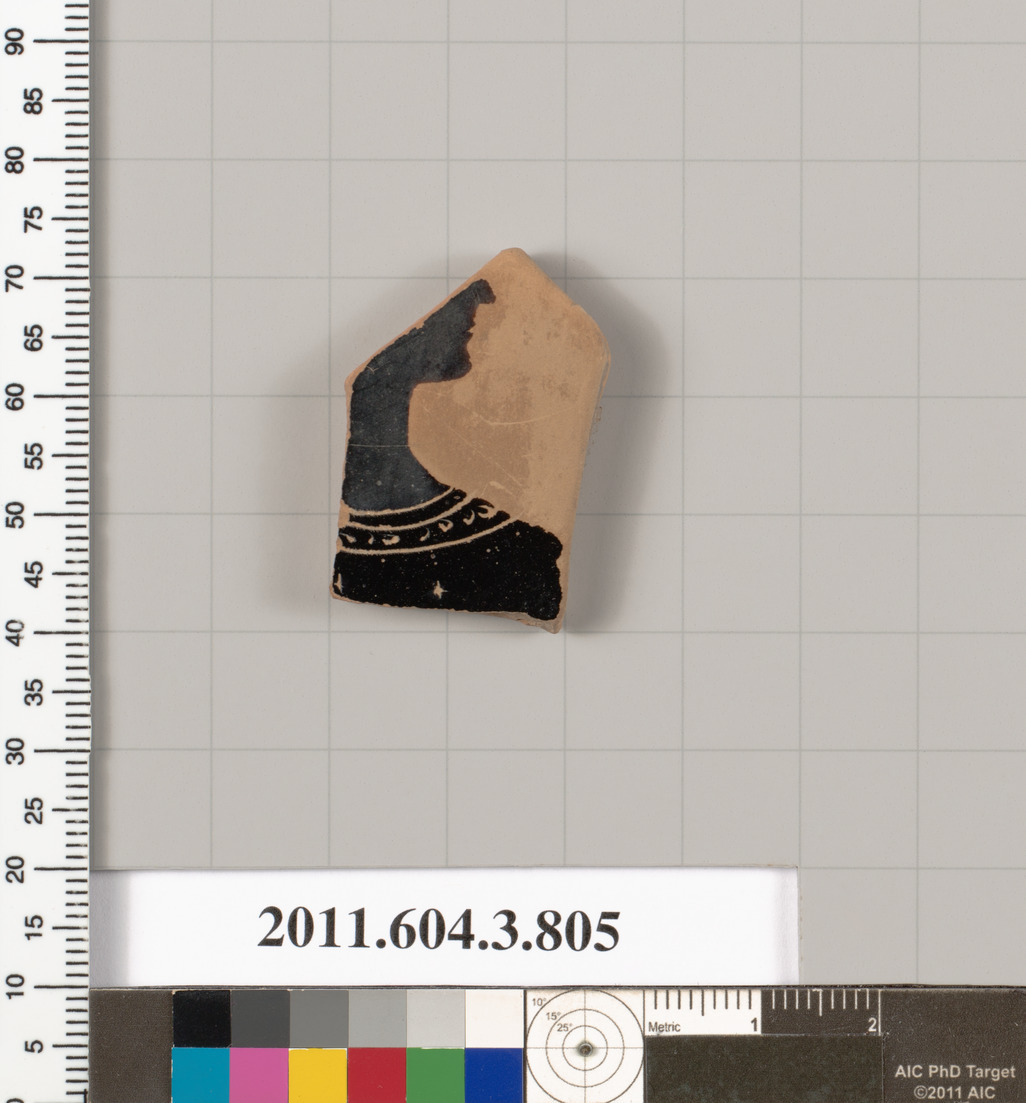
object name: lekythos fragment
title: Terracotta fragment of a lekythos (oil flask)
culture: greek, attic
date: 550-501 BCE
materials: terracotta